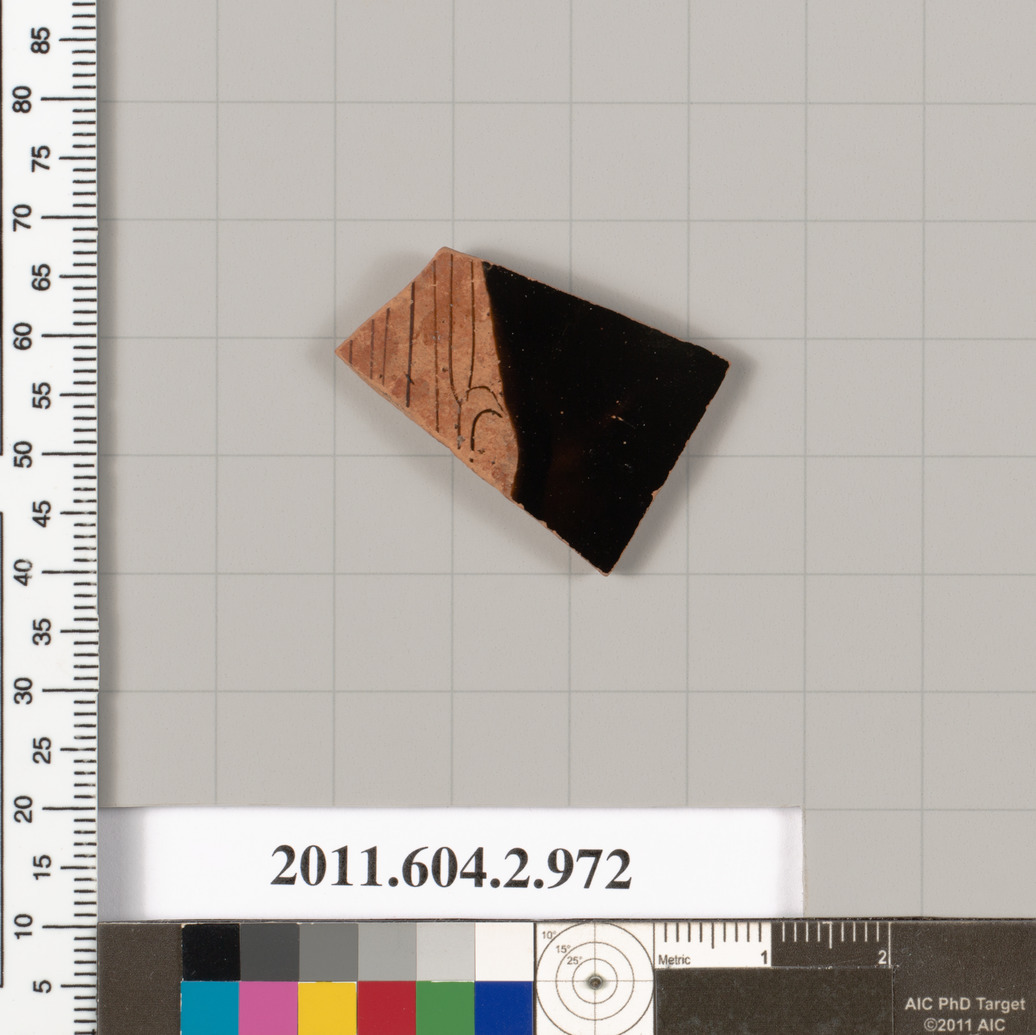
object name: oinochoe fragment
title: Terracotta fragment of an oinochoe (jug)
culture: greek, attic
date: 460-450 BCE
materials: terracotta